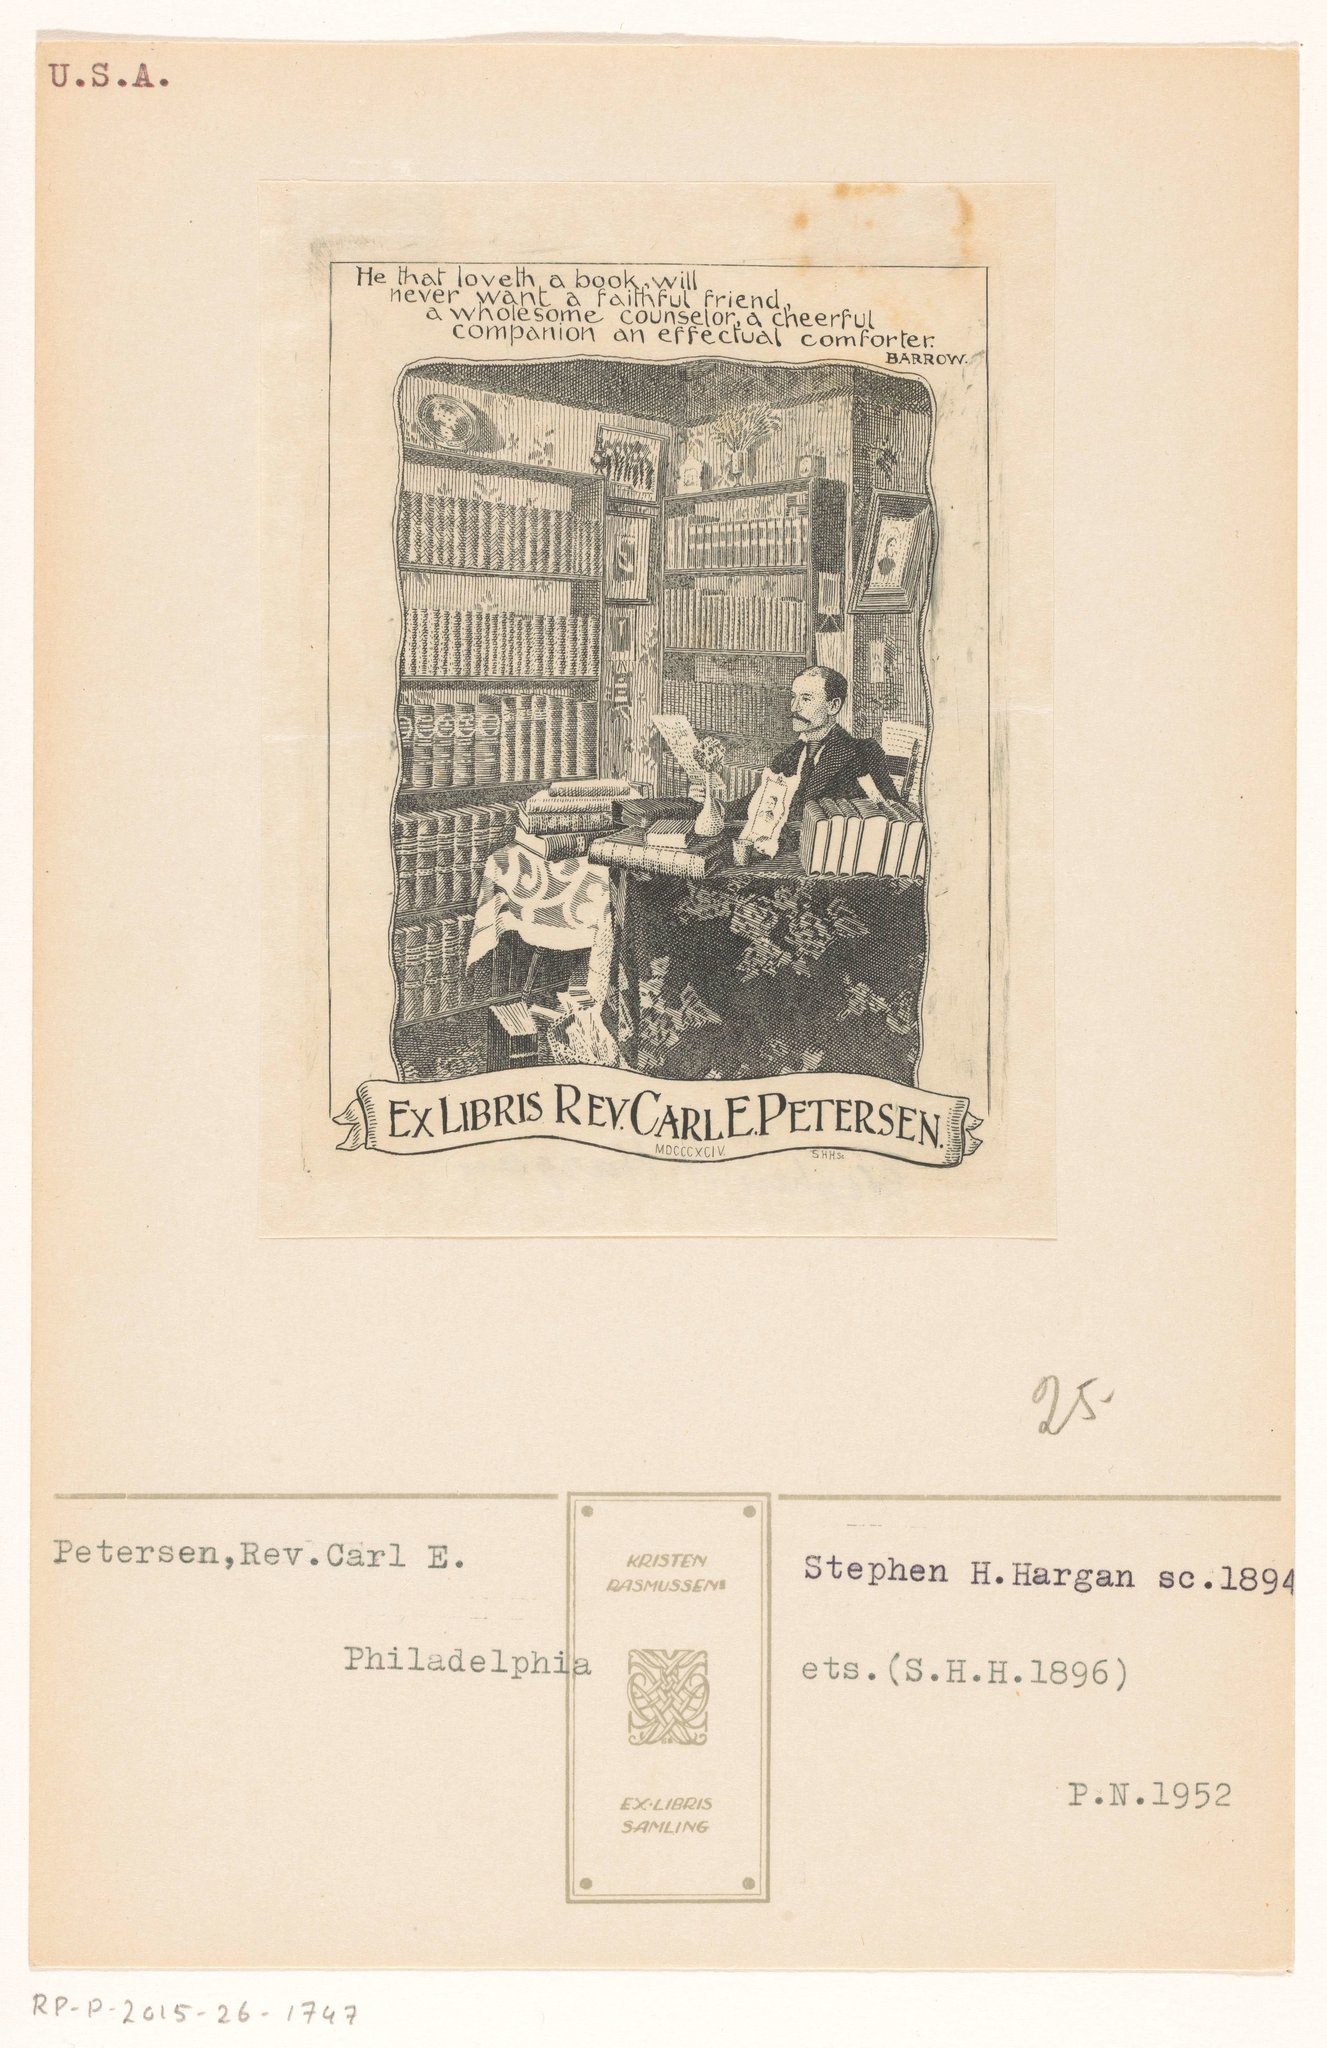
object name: bookplate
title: Ex libris van Carl E. Petersen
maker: stephen h. hargan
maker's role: print maker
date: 1894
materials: paper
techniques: etching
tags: bookshelves, reading, study; 'studiolo'; library, letter, envelope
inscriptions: annotation: ‘Stephen H. Hargan’, collector's mark: Lugt 2228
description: Portret van een man in zijn studeerkamer, mogelijk Carl E. Petersen. In zijn handen houdt hij een brief. Boven een drieregelig citaat van Isaac Barrow.